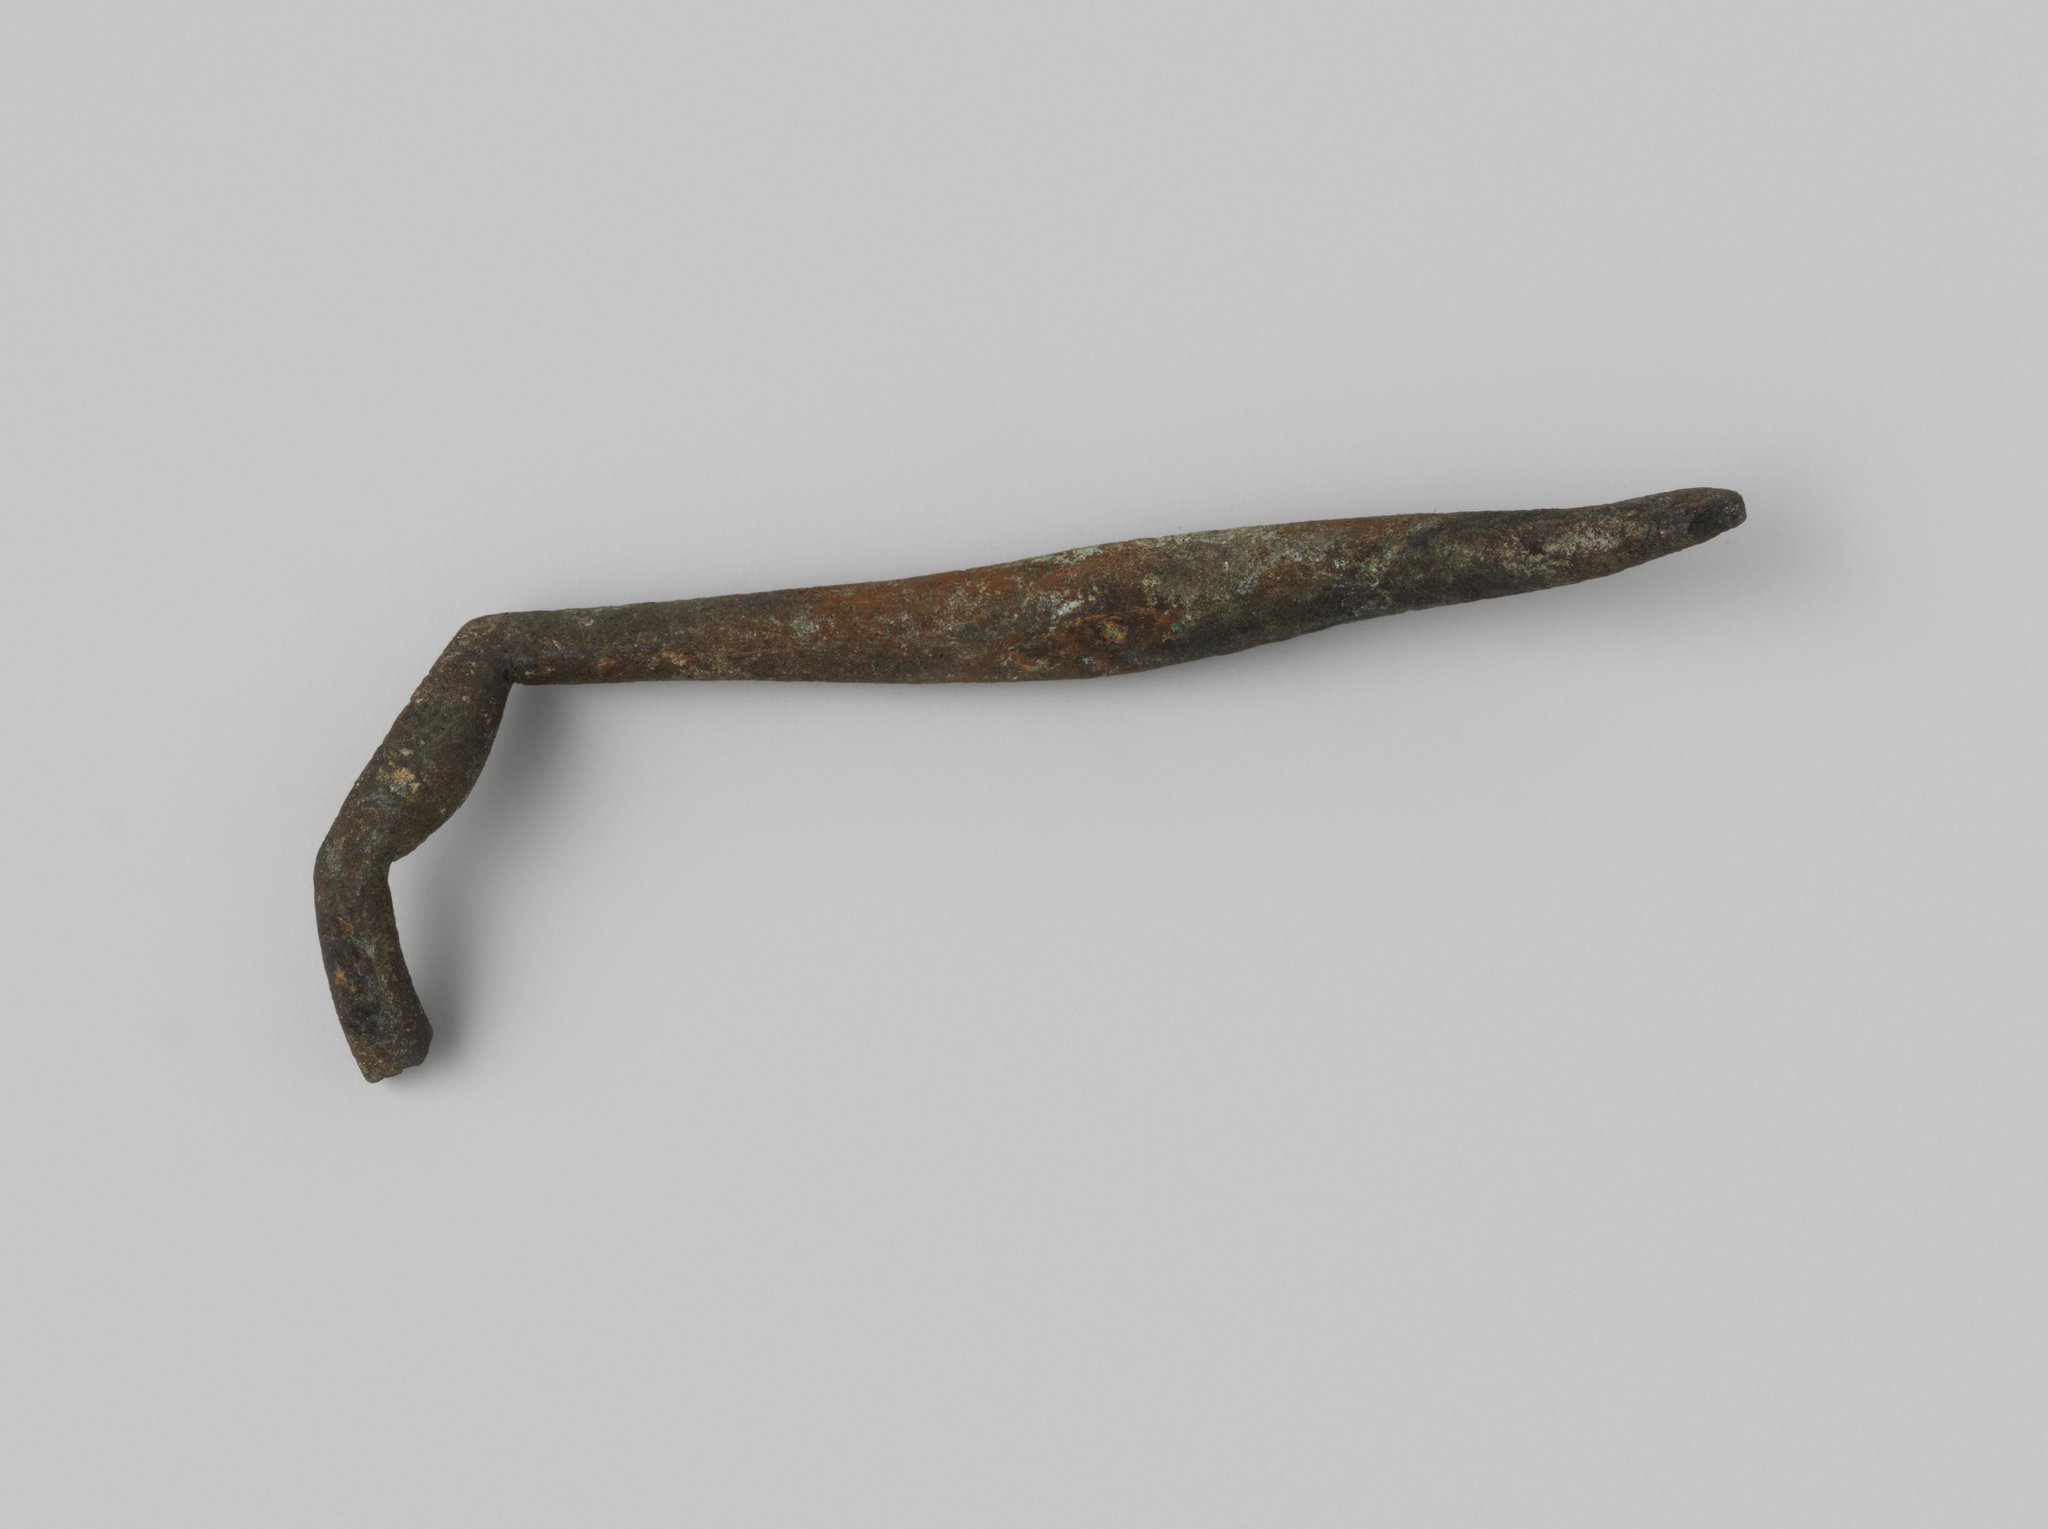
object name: shoe buckle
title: Fragment schoengesp uit het wrak van de Oost-Indiëvaarder Hollandia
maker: Anonymous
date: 1700-1743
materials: copper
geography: netherlands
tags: verenigde oostindische compagnie, hollandia (schip), annet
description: Buckle, chape buckle, shoe buckle; fragment of ring, id. NG 1980-27H2495.